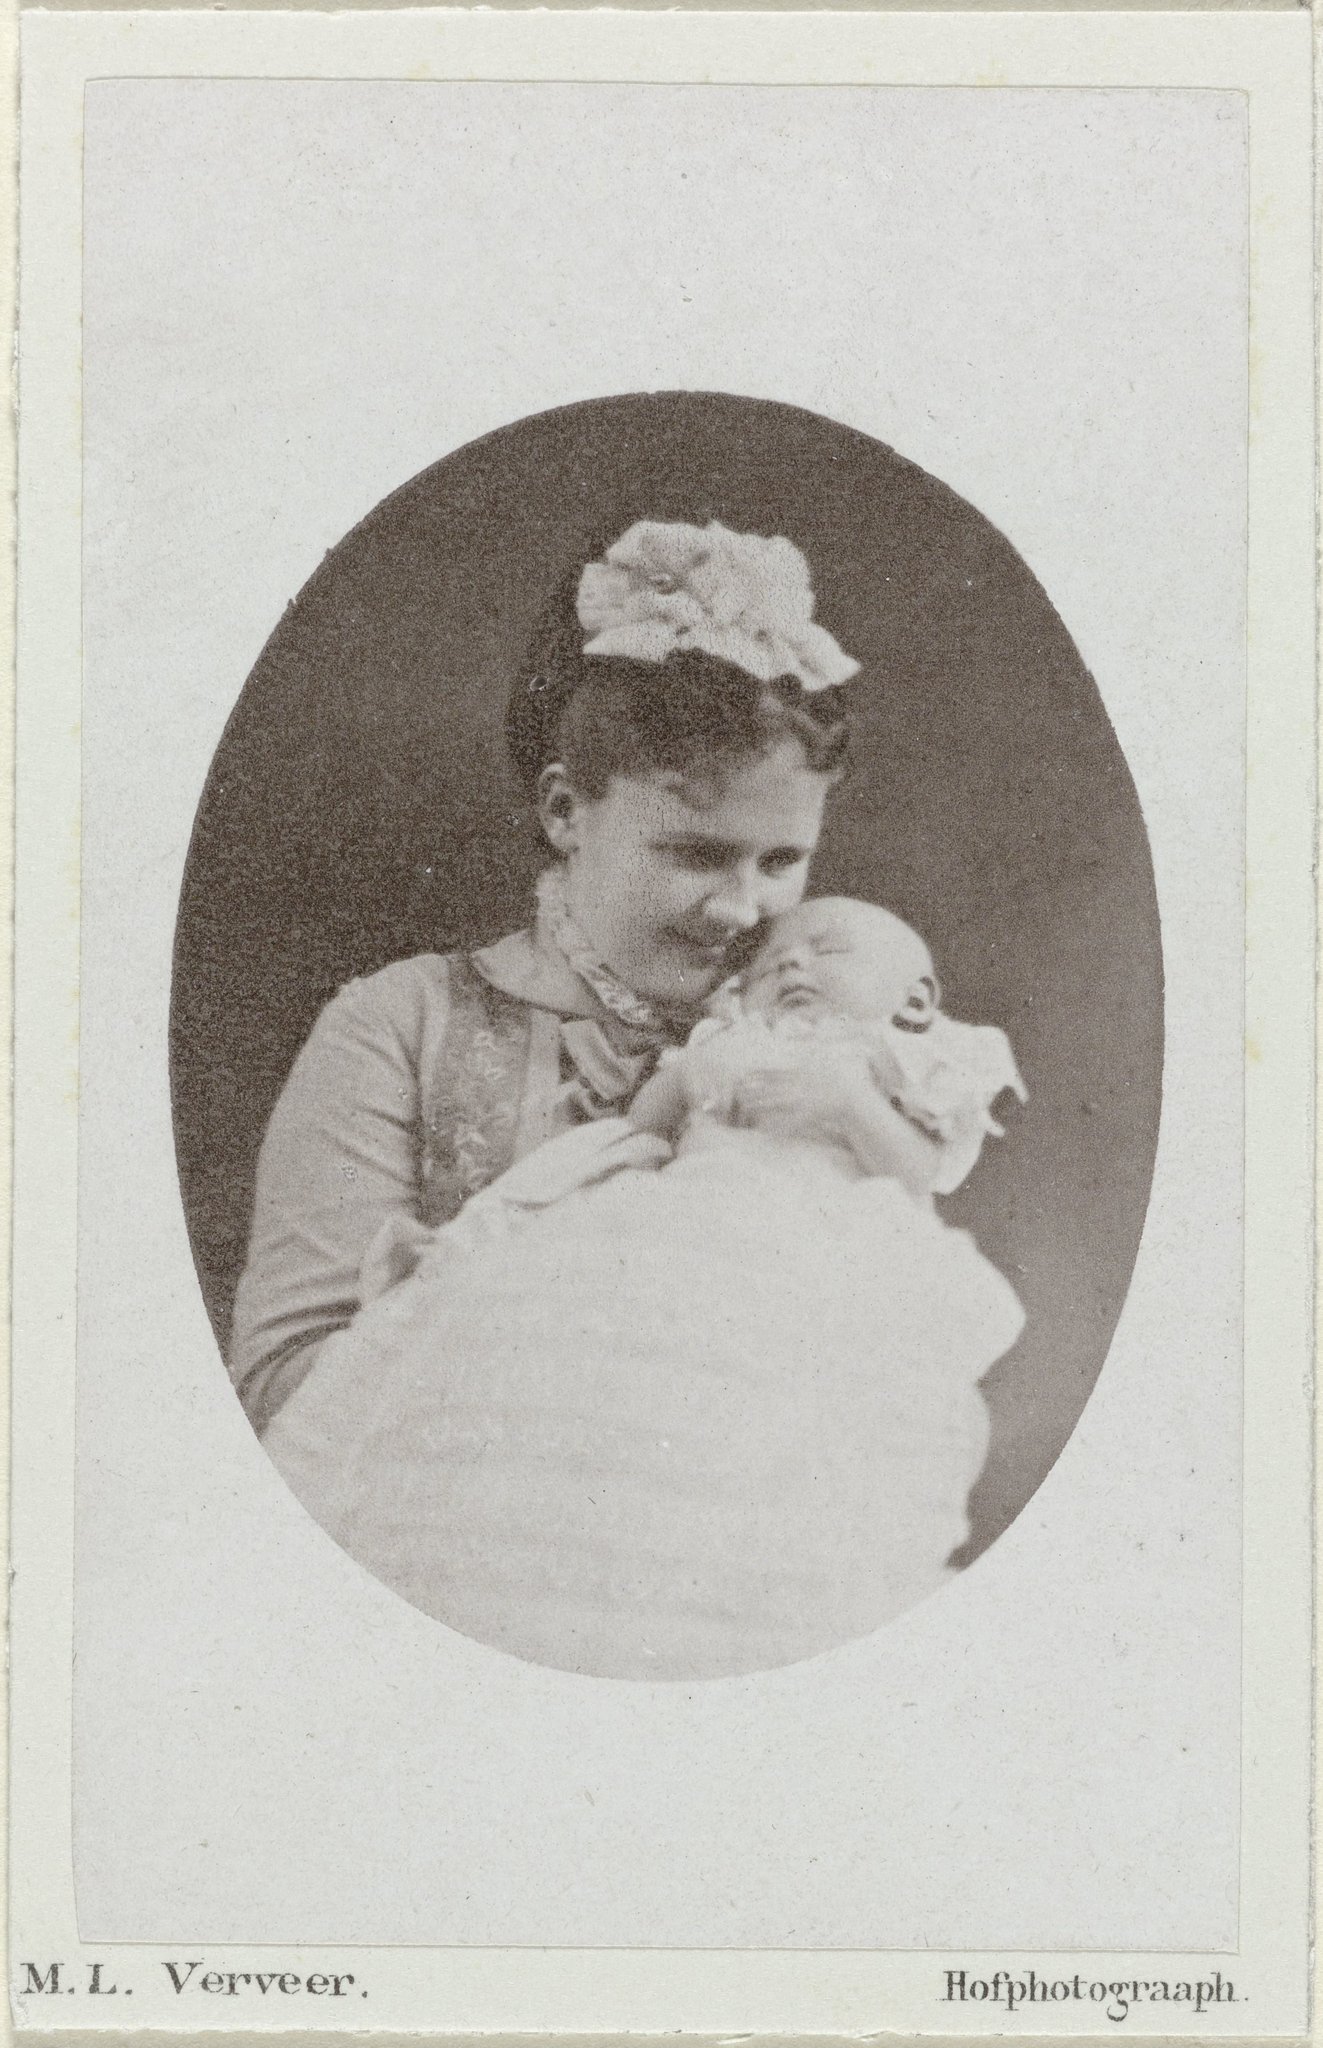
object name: photomechanical print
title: Portret van Emma, koningin-regentes der Nederlanden, en Wilhelmina, koningin der Nederlanden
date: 1880-1882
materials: cardboard, paper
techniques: photograph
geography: netherlands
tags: the hague, wilhelmina of the netherlands, emma (queen consort of the netherlands)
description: De hier vermelde titel verwijst naar de hoogst verkregen titel van de geportretteerde, niet per se naar de titel die de geportretteerde op deze voorstelling draagt.